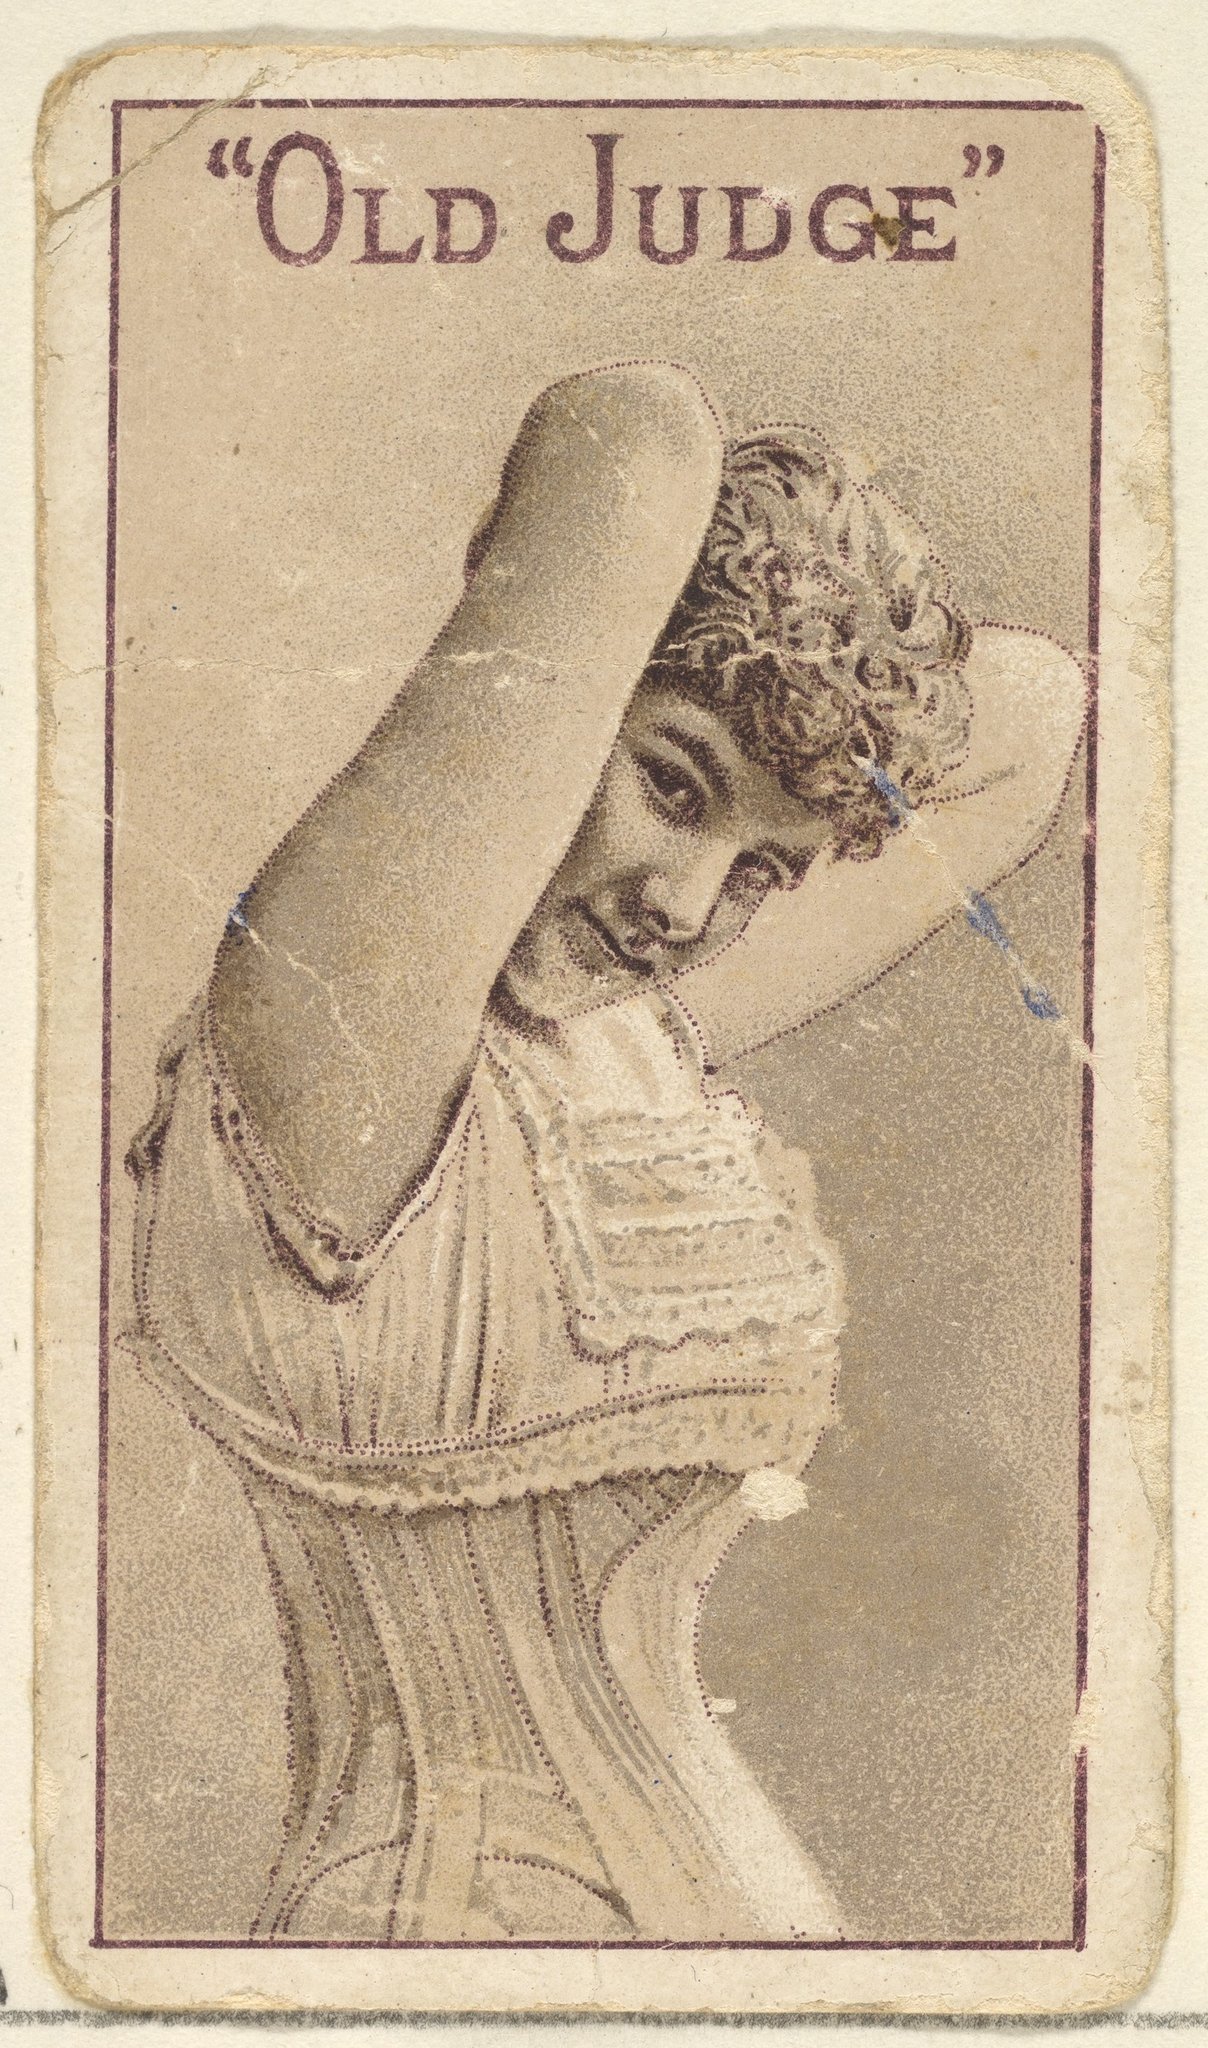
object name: print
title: Actress from the Old Judge series (N167) for Old Judge Cigarettes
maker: goodwin & company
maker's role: publisher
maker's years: 1850-1950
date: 1886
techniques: lithography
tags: portraits,women